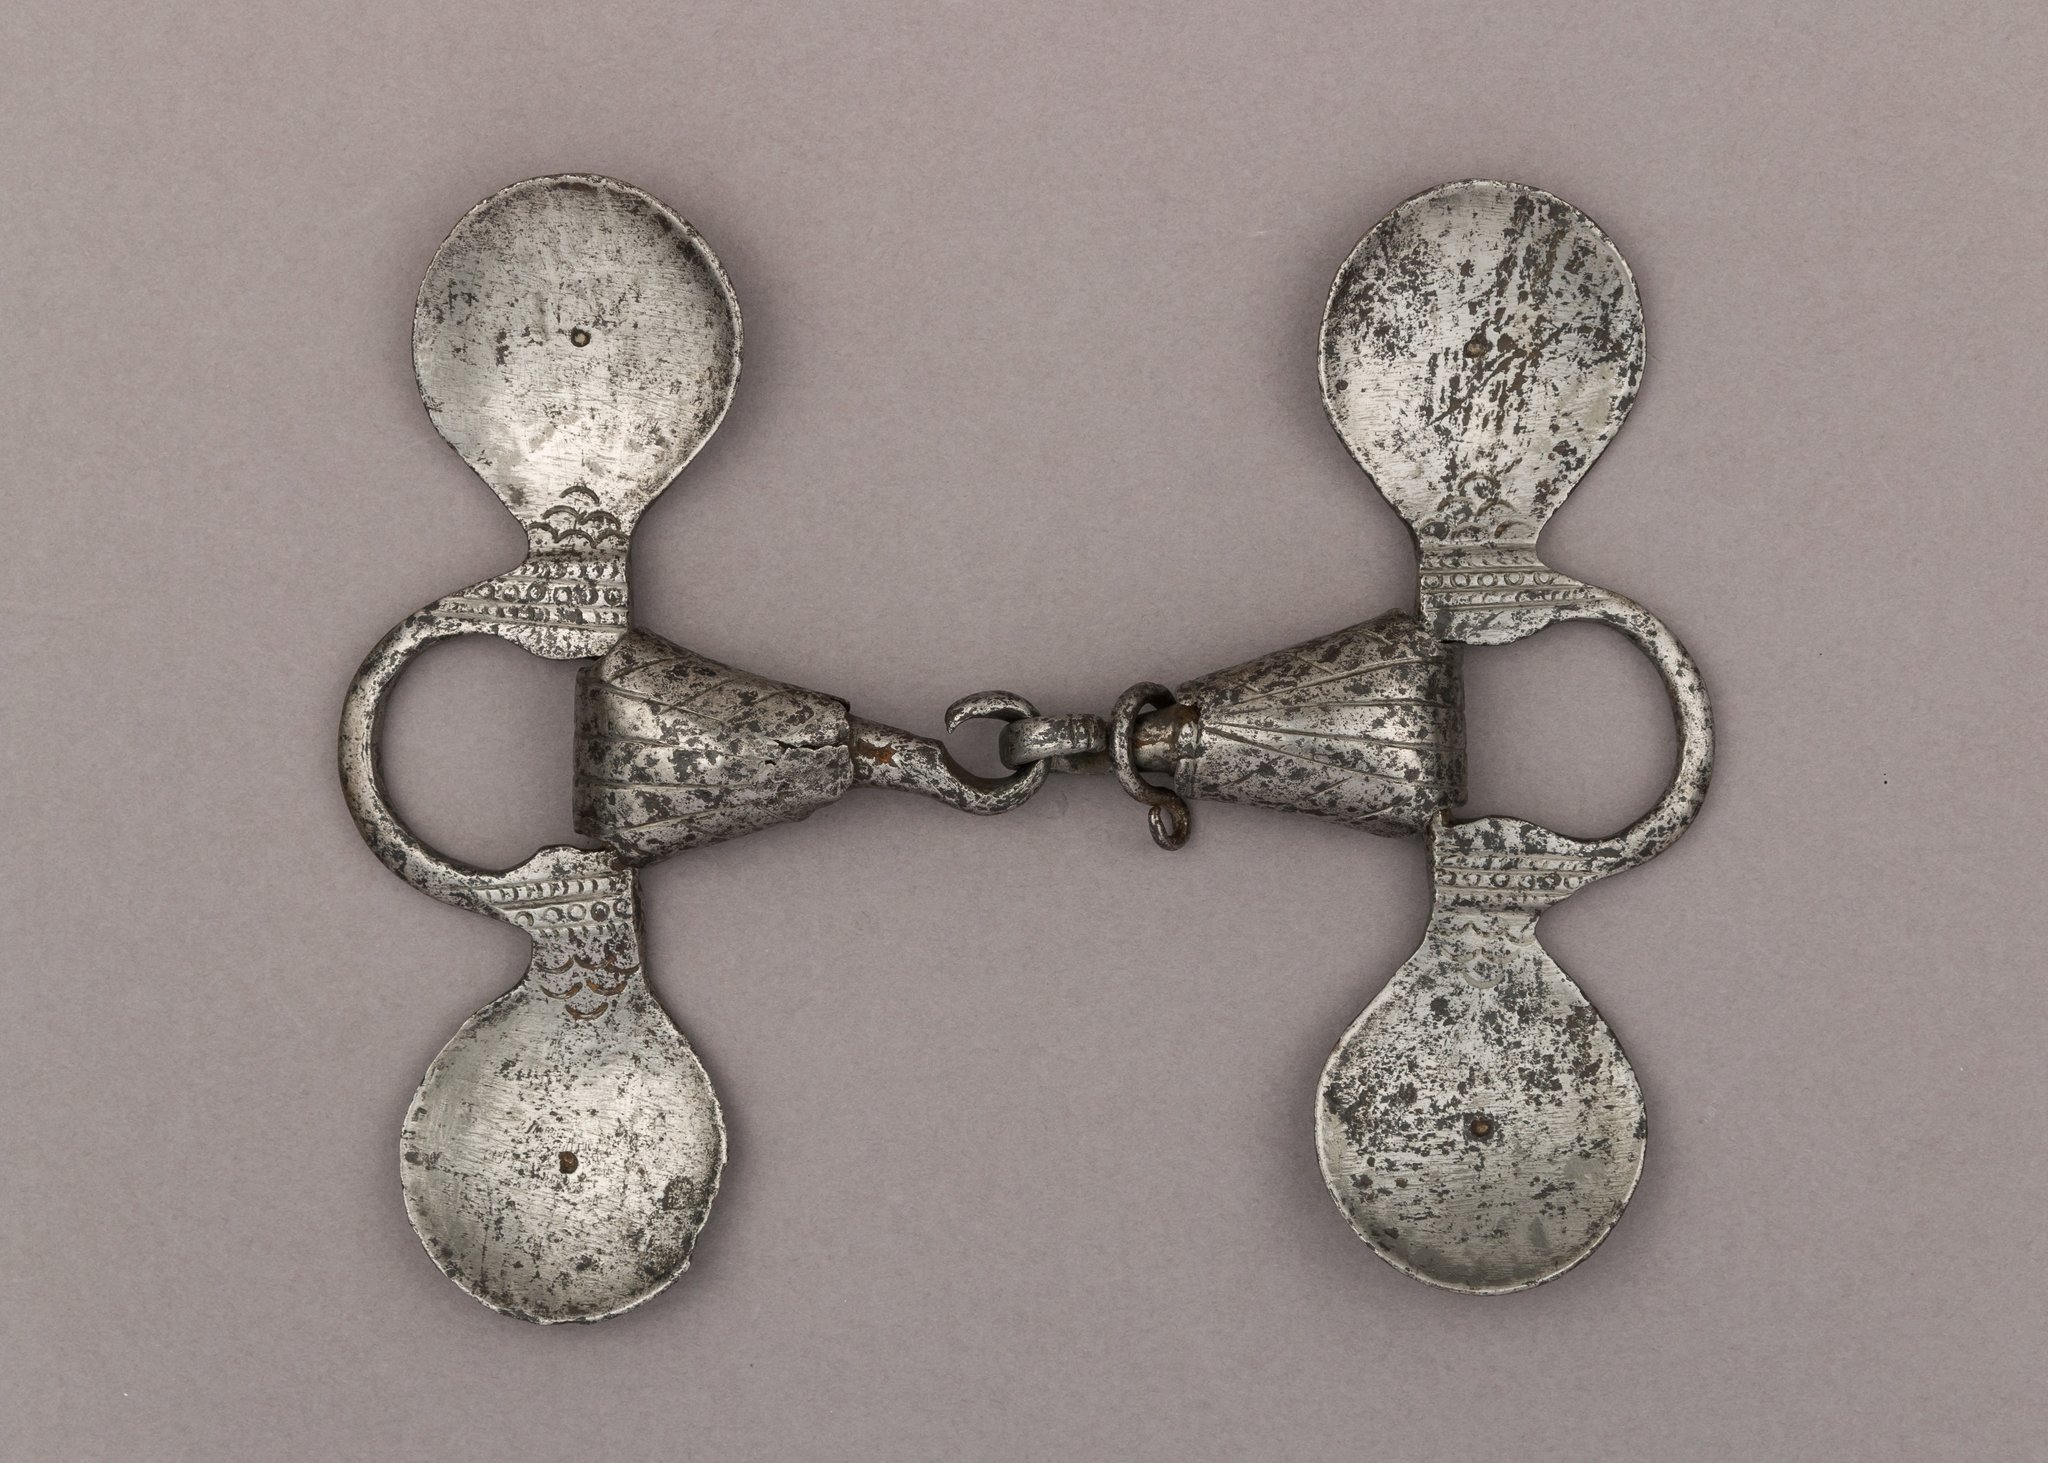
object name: bit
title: Snaffle Bit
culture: german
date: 1567-1700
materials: metal alloy, tin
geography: germany